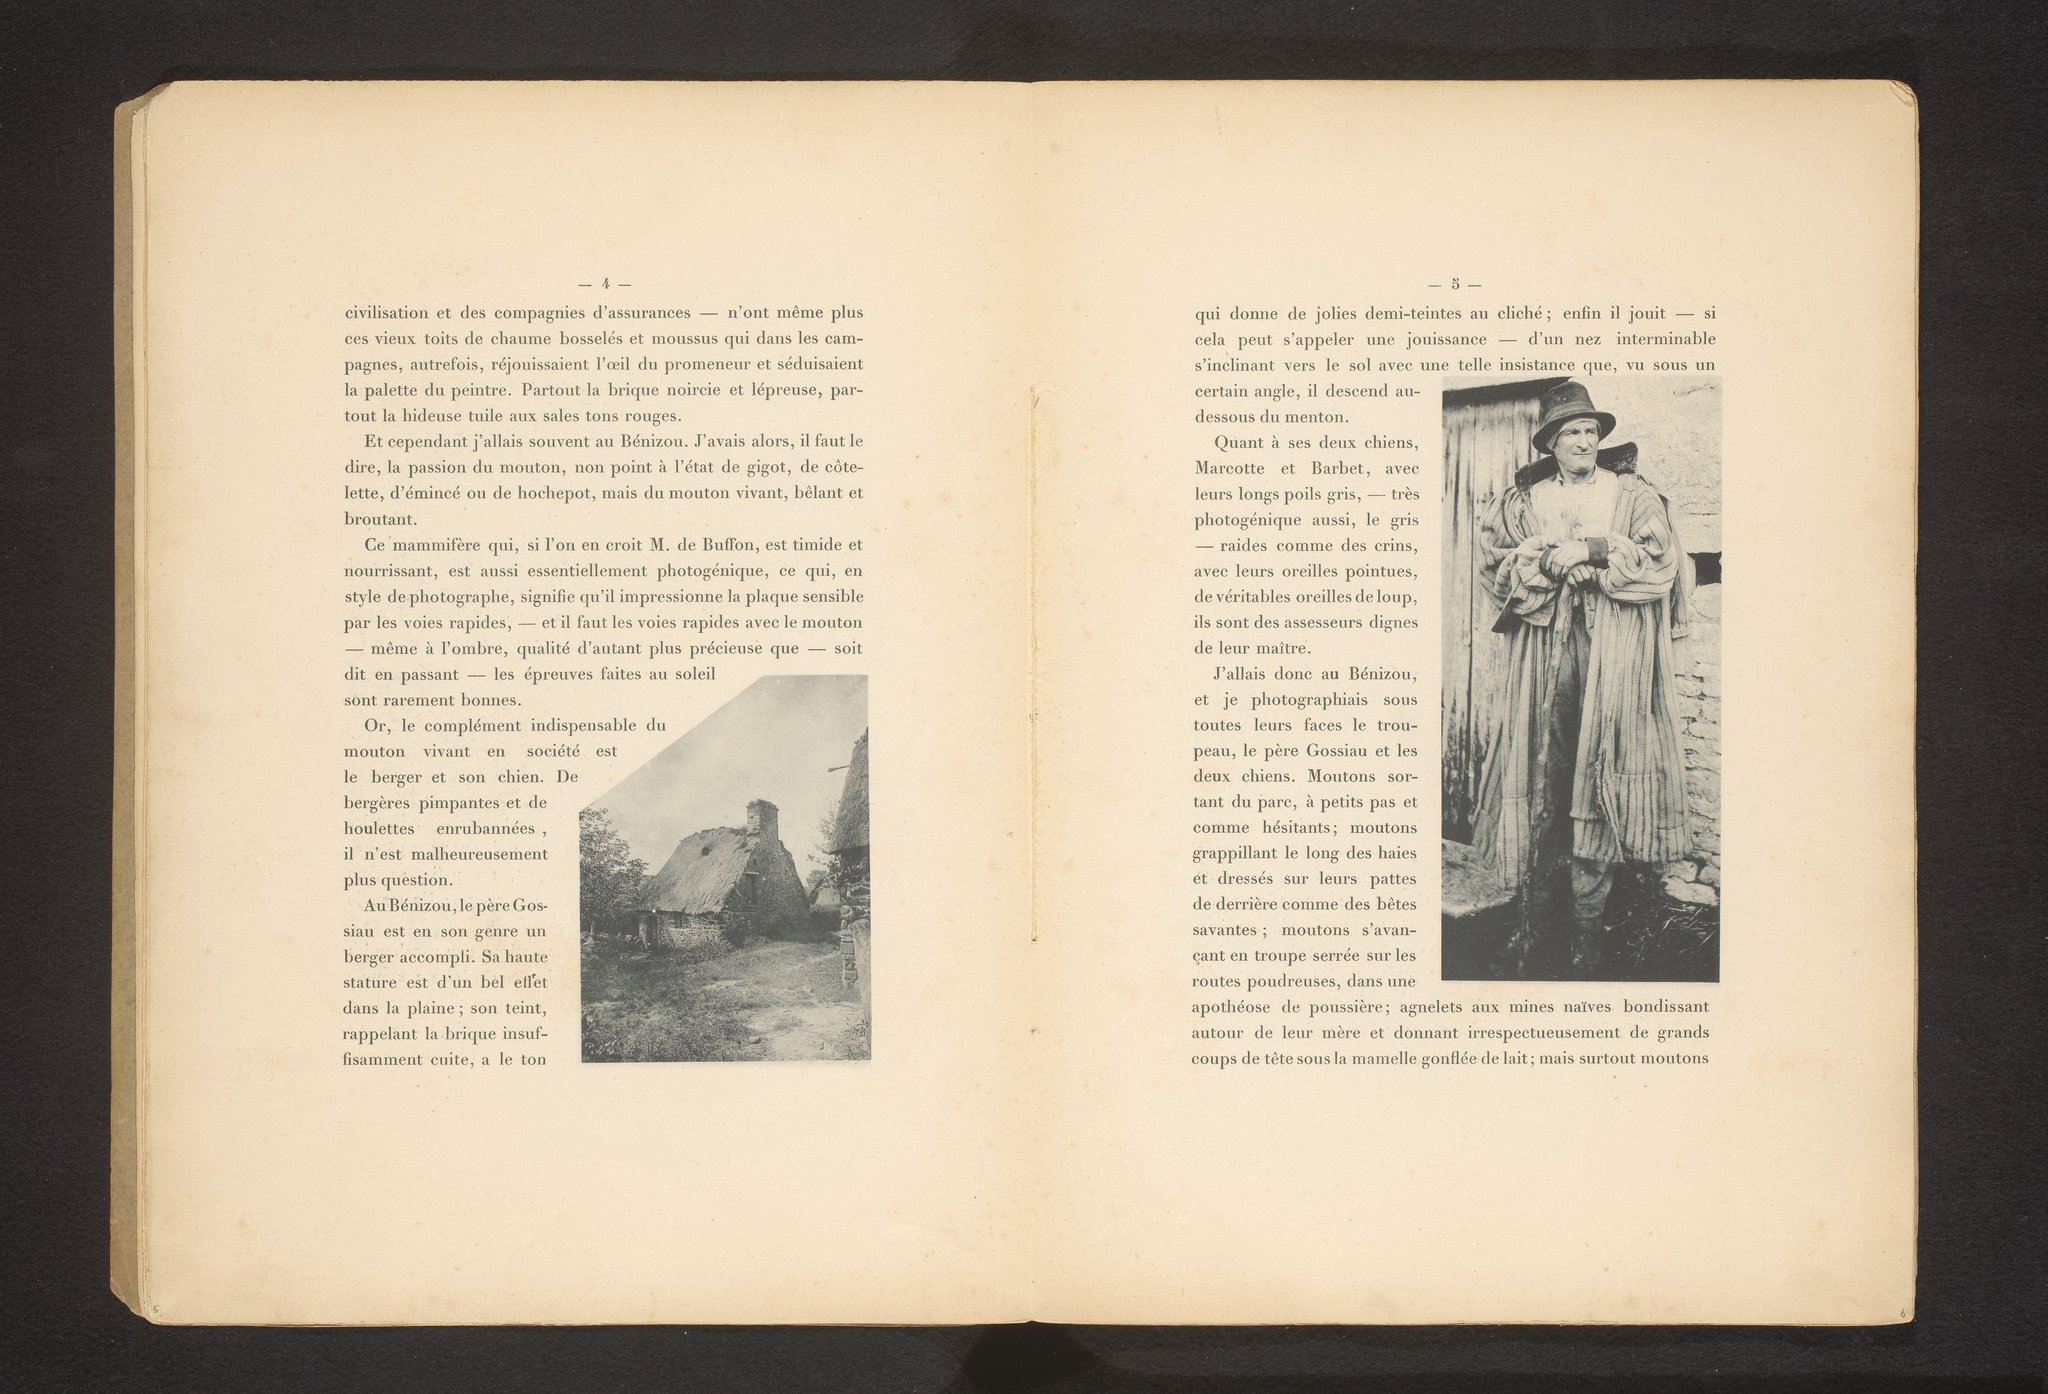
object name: photomechanical print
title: Gezicht op een boerderij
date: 1885-1895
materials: paper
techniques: photograph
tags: farm (building)